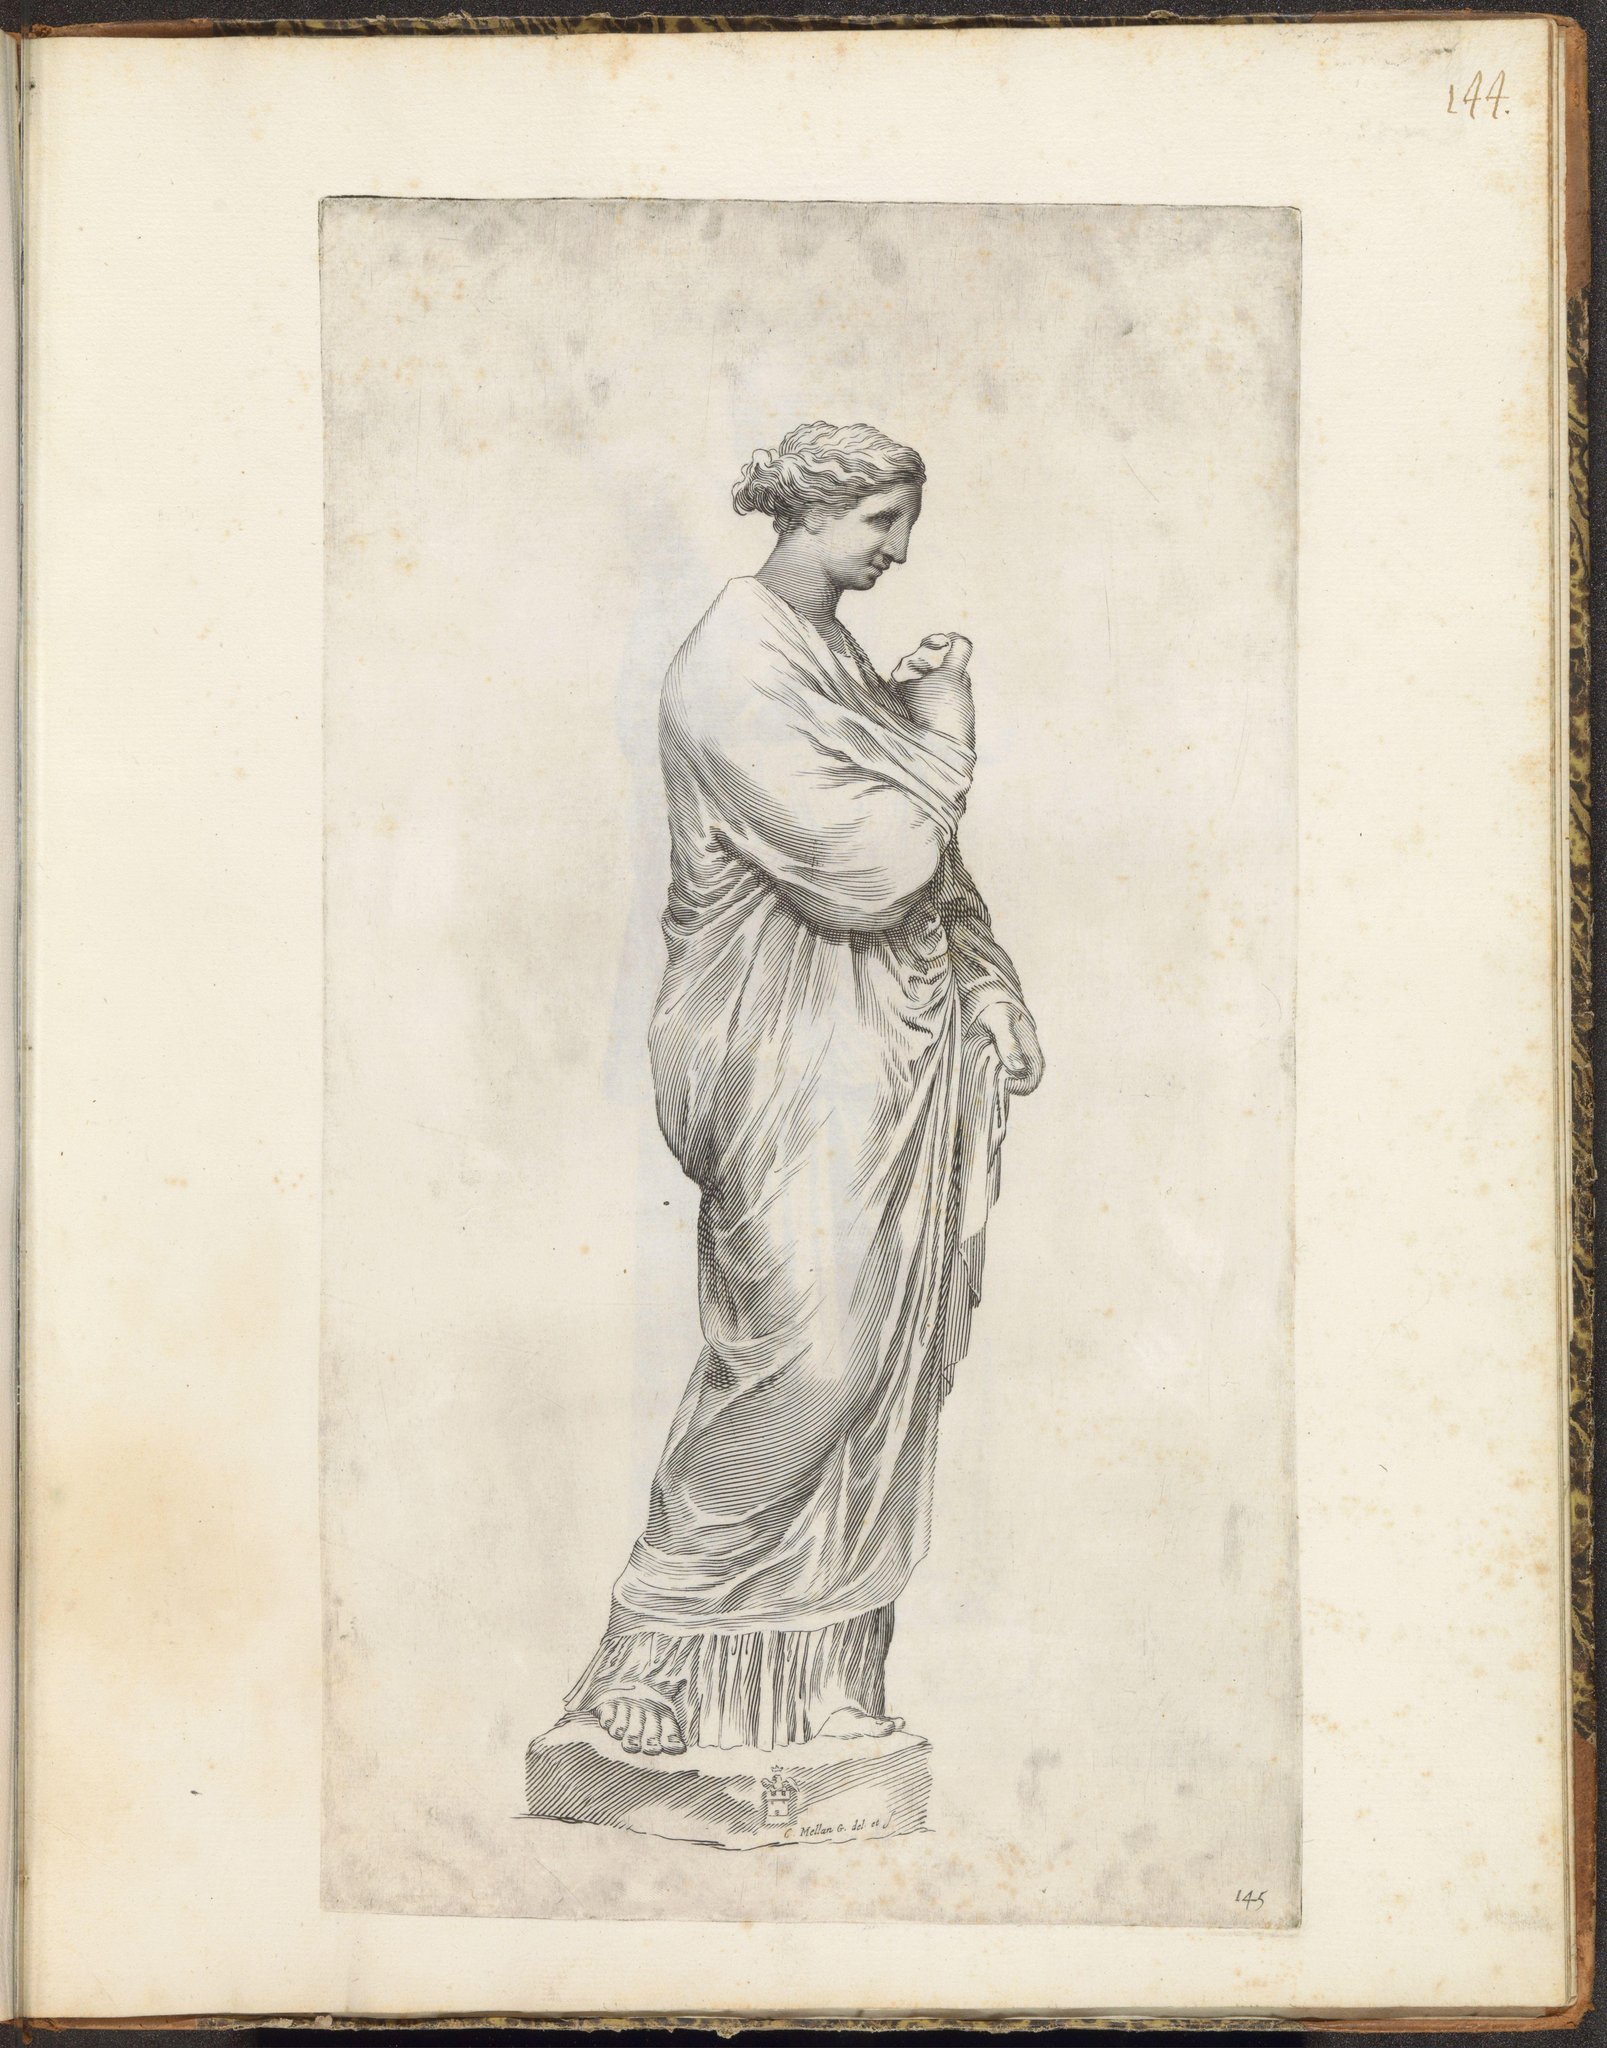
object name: album leaf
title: Standbeeld van een geklede vrouw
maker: claude mellan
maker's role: draughtsman, print maker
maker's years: 1598-1688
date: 1636-1647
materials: paper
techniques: engraving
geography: rome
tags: piece of sculpture, reproduction of a piece of sculpture, female persons from classical history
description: Standbeeld van een staande vrouw gekleed in klassiek gewaad. Midden onder het wapenschild van Vincenzo Giustiniani. Prent maakt deel uit van een album met een serie prenten naar de sculpturen in de verzameling in de Galleria Giustiniani te Rome.